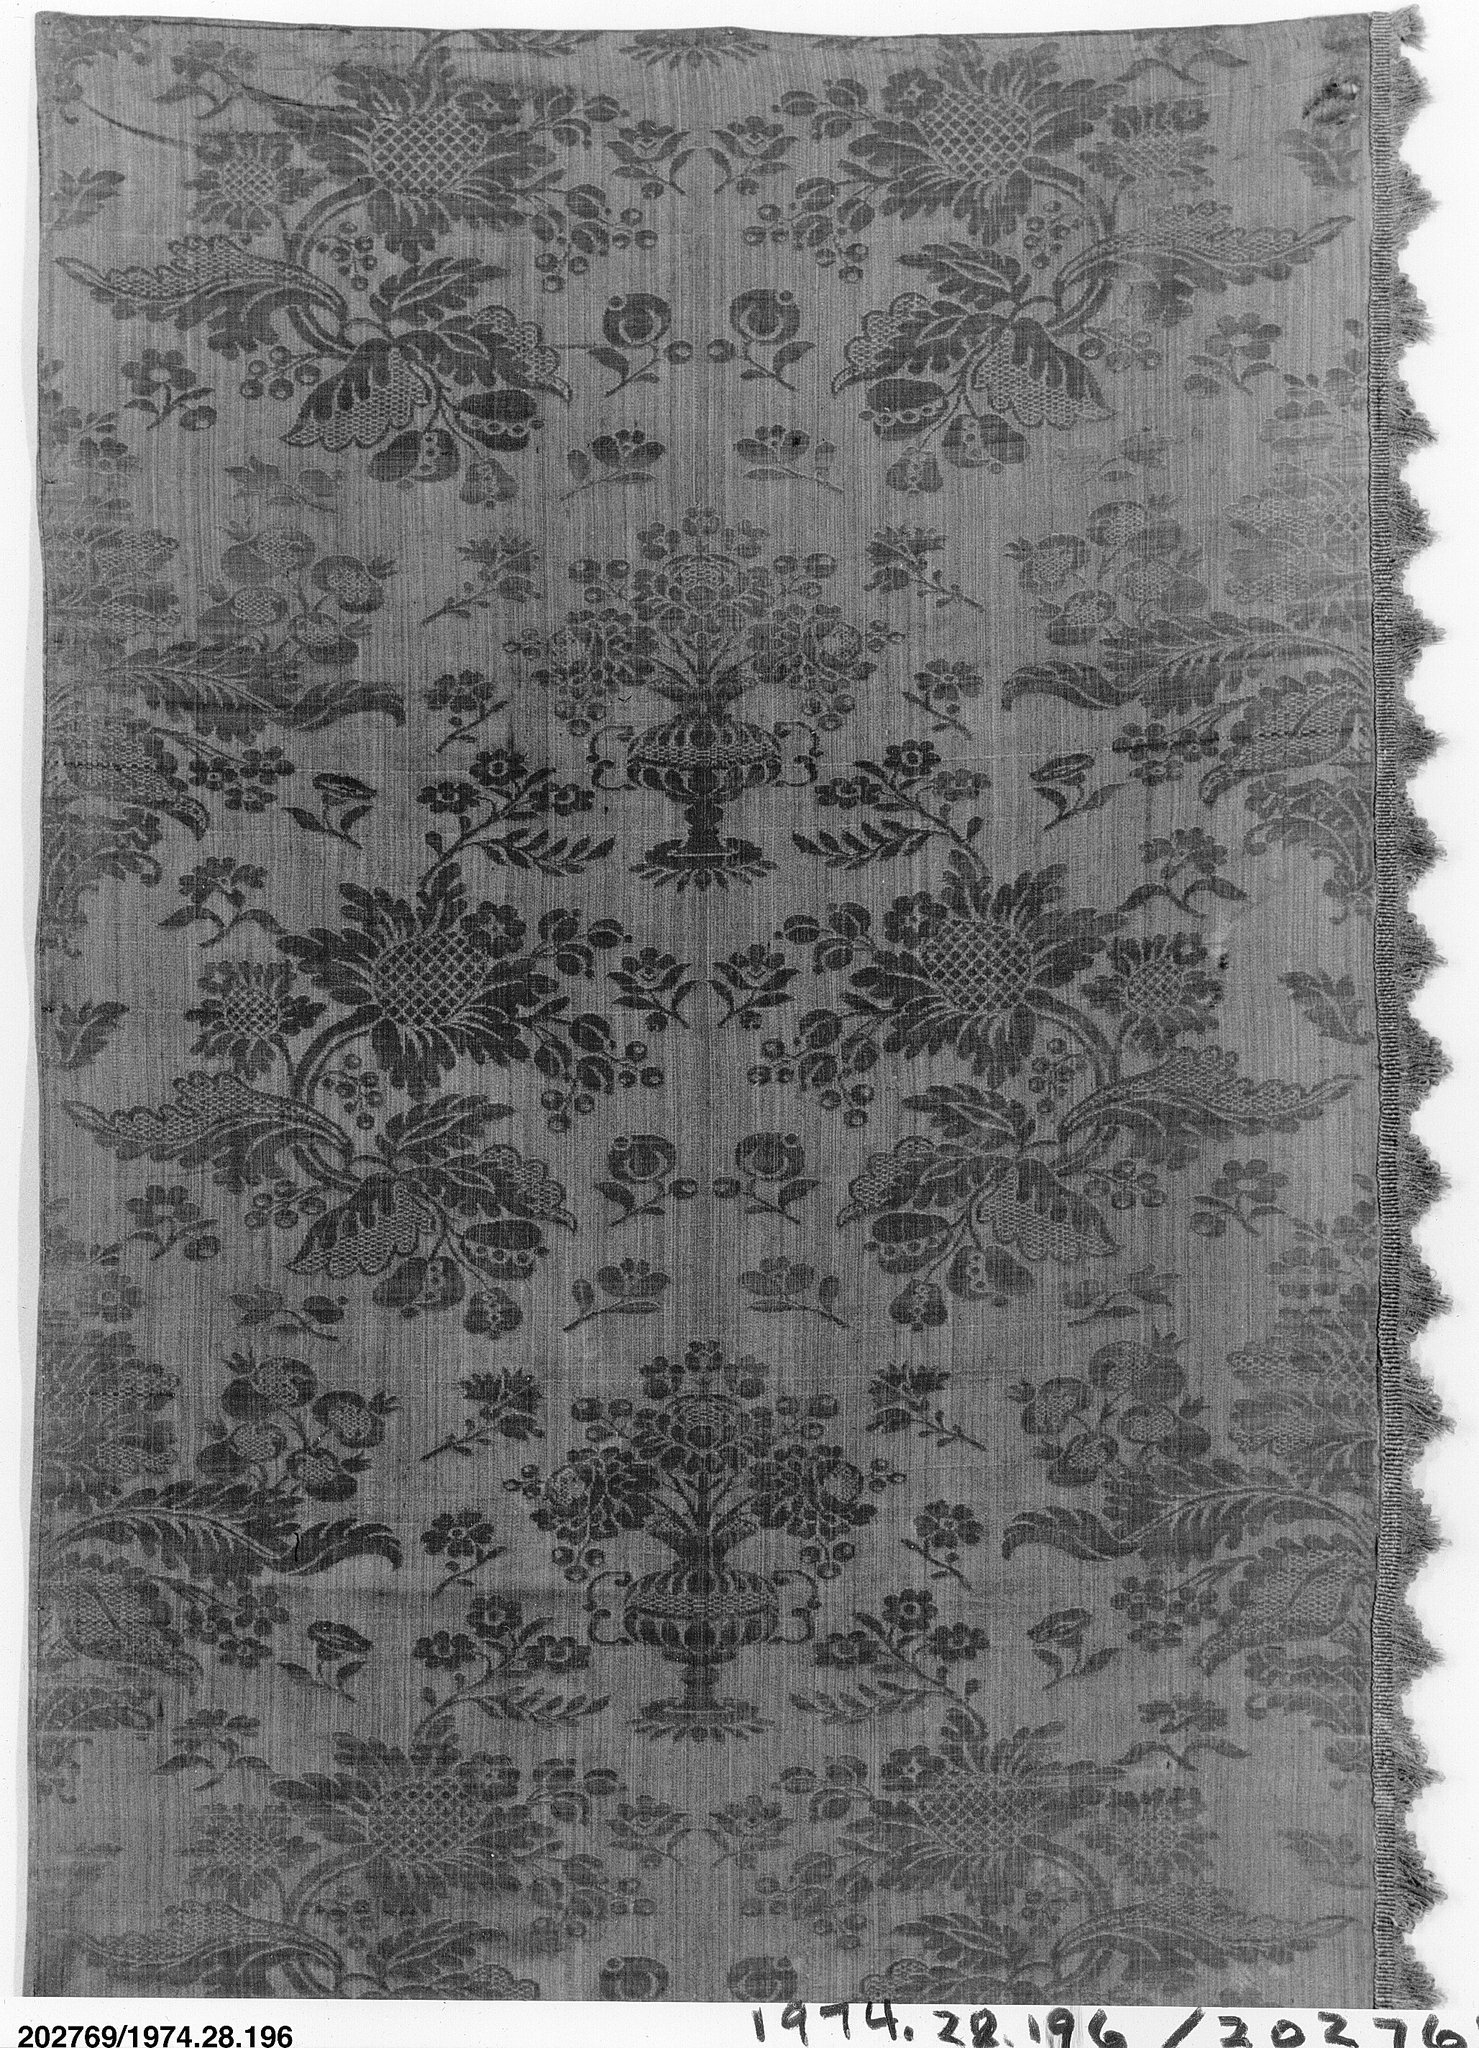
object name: panel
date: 1730-1739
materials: silk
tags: flowers